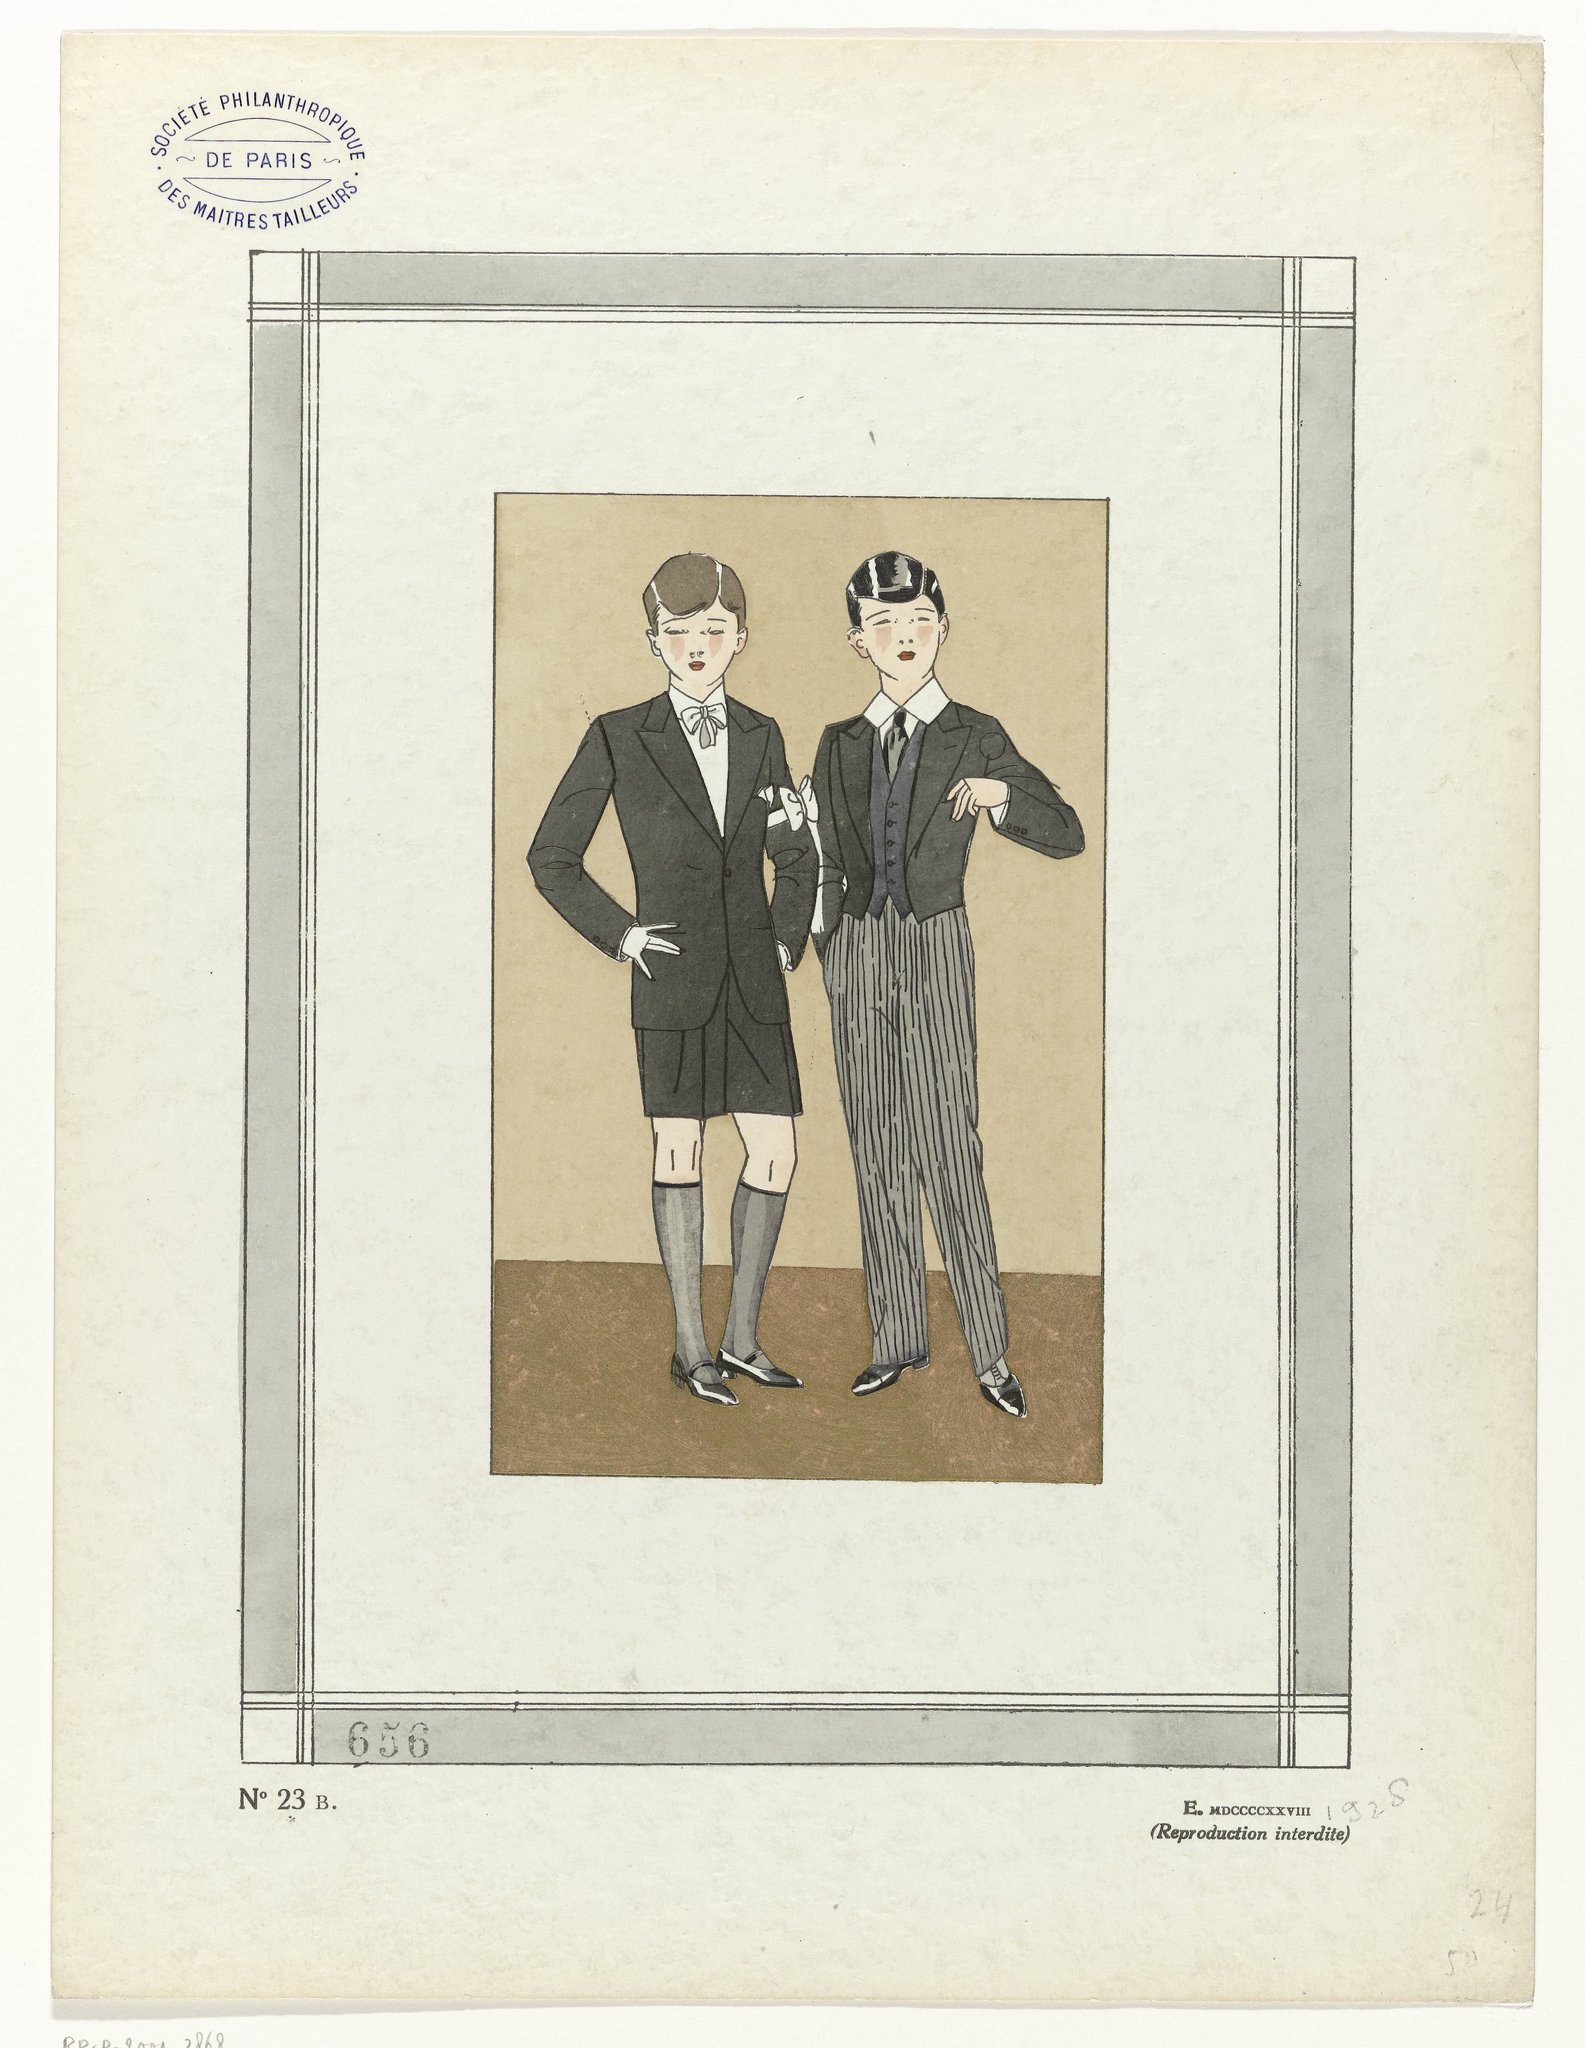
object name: fashion print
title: Société Philanthropique des maitres tailleurs, 1928, No. 23 B, Nr. 656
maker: Anonymous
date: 1928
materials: paper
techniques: engraving, hand coloring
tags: trousers, breeches (+ boys' clothes), coat (+ boys' clothes), fashion plates, trousers, breeches, etc. (breeches) (+ men's clothes)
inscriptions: stamp: ‘Société Philamthropique ~ De Paris ~ Des Maitres Tailleurs’